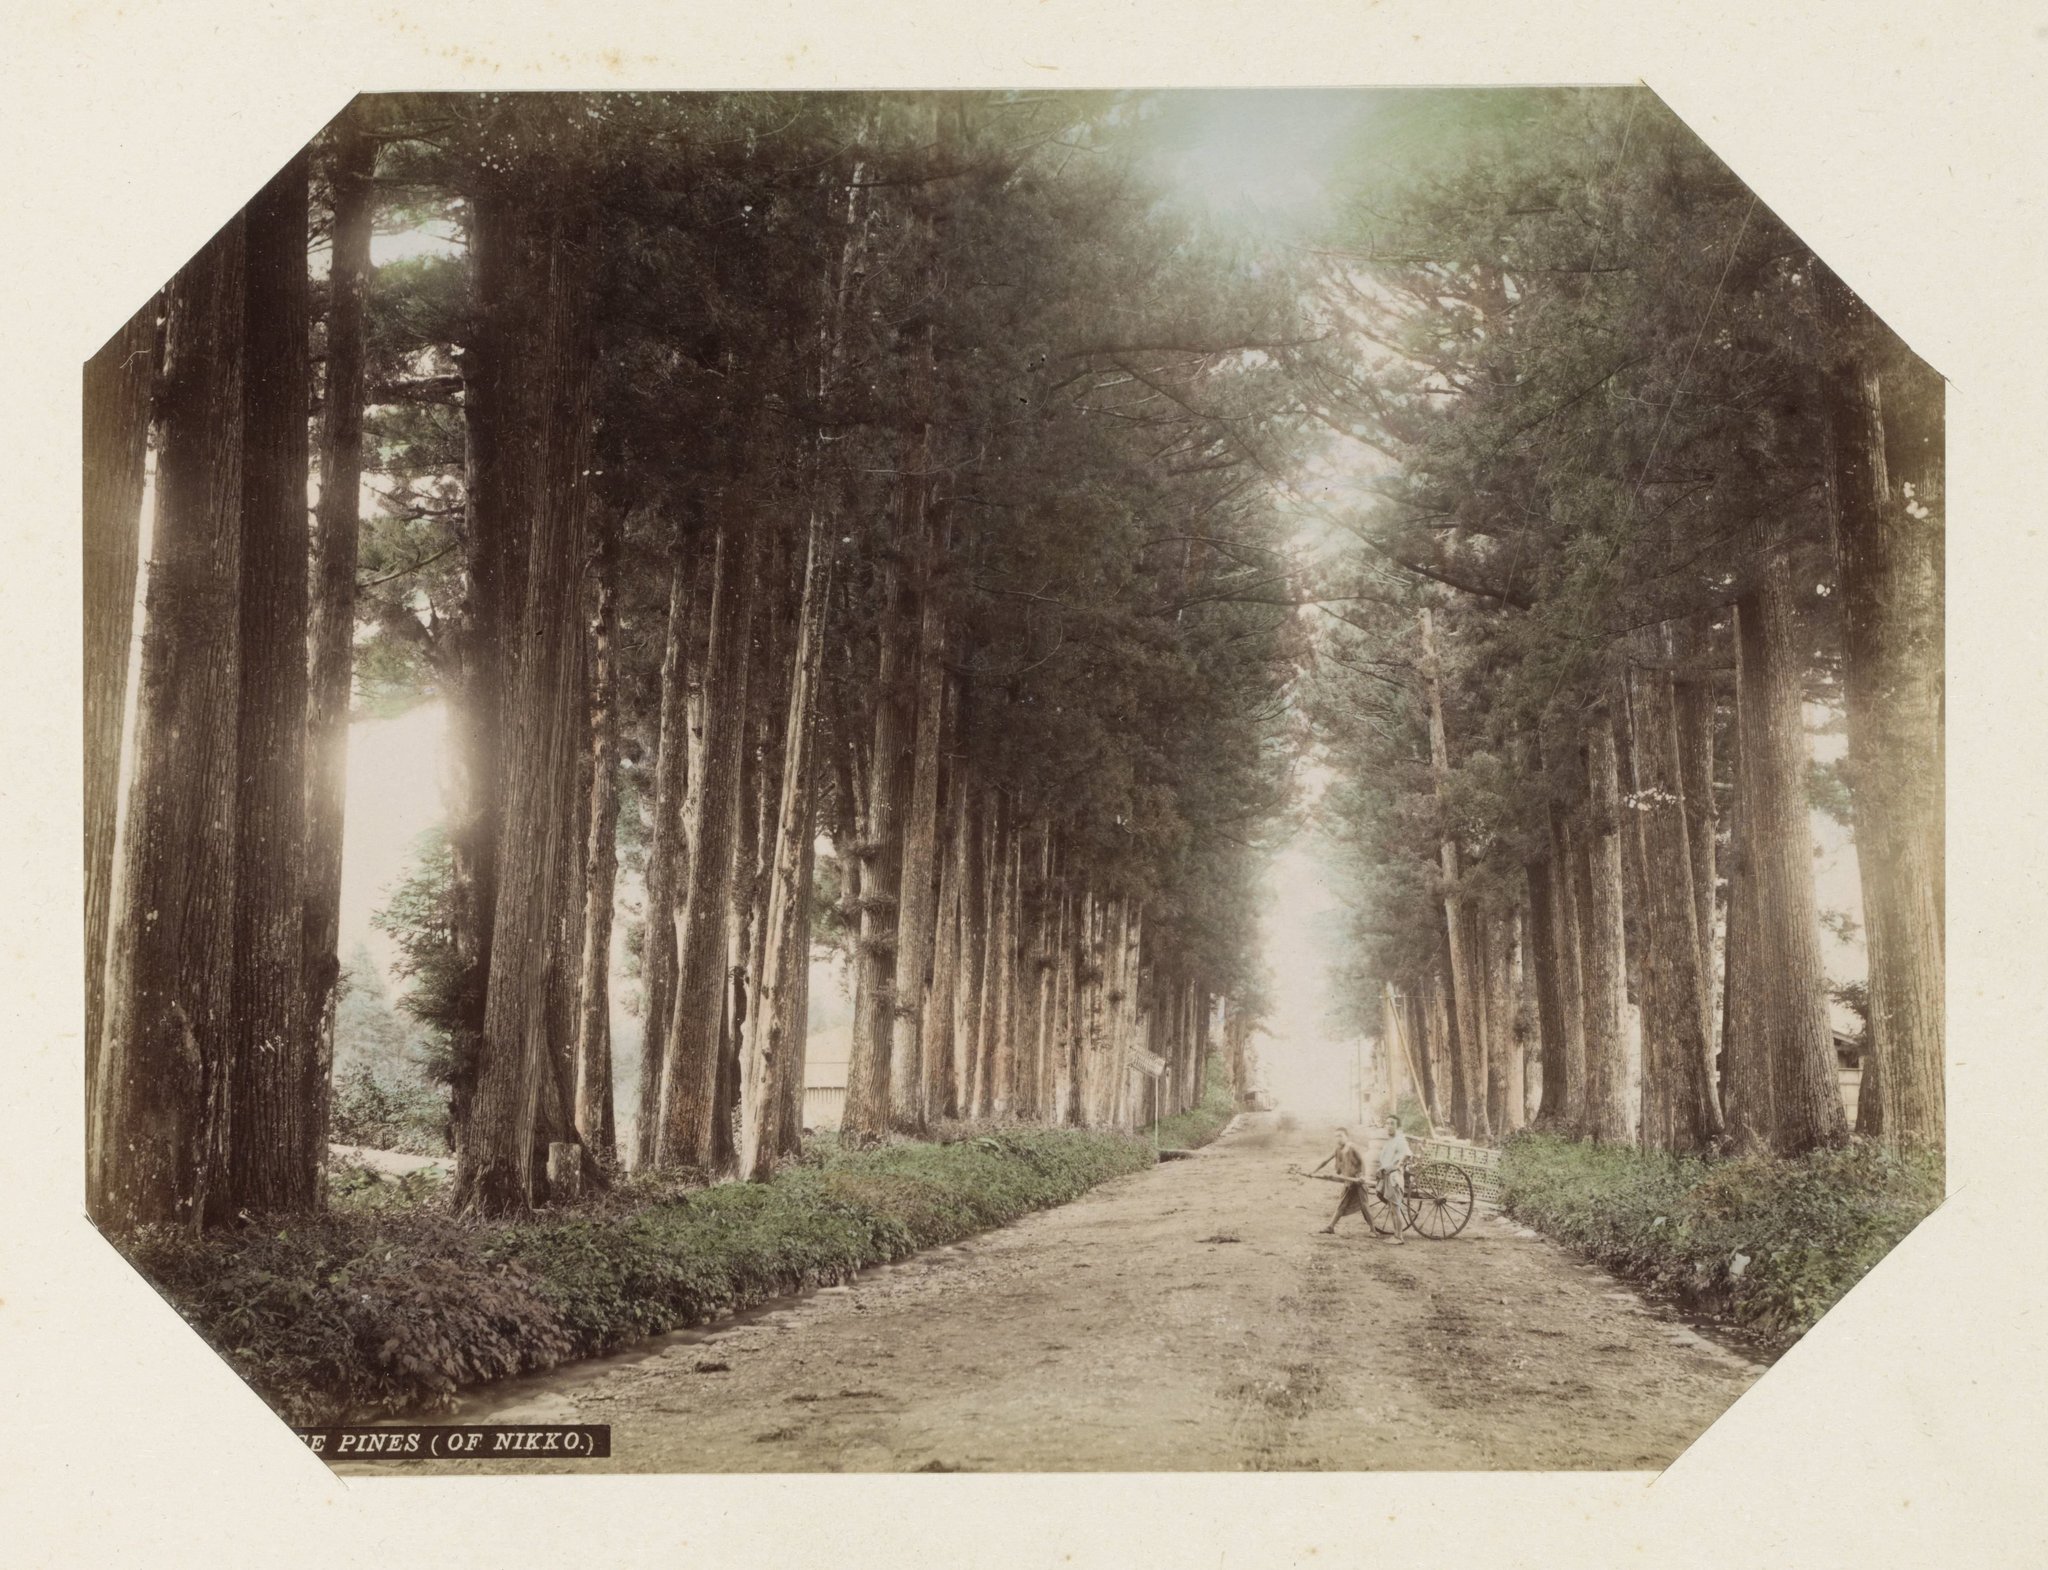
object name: photograph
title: Japanese Pines (of Nikko)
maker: Anonymous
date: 1870-1900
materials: paint, photographic support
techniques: albumen print, hand coloring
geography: nikko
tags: hand-cart, forest path or lane, trees: pine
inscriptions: number: ‘I 3’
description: Onderdeel van Fotoalbum met opnames van bezienswaardigheden in Japan en studioportretten.